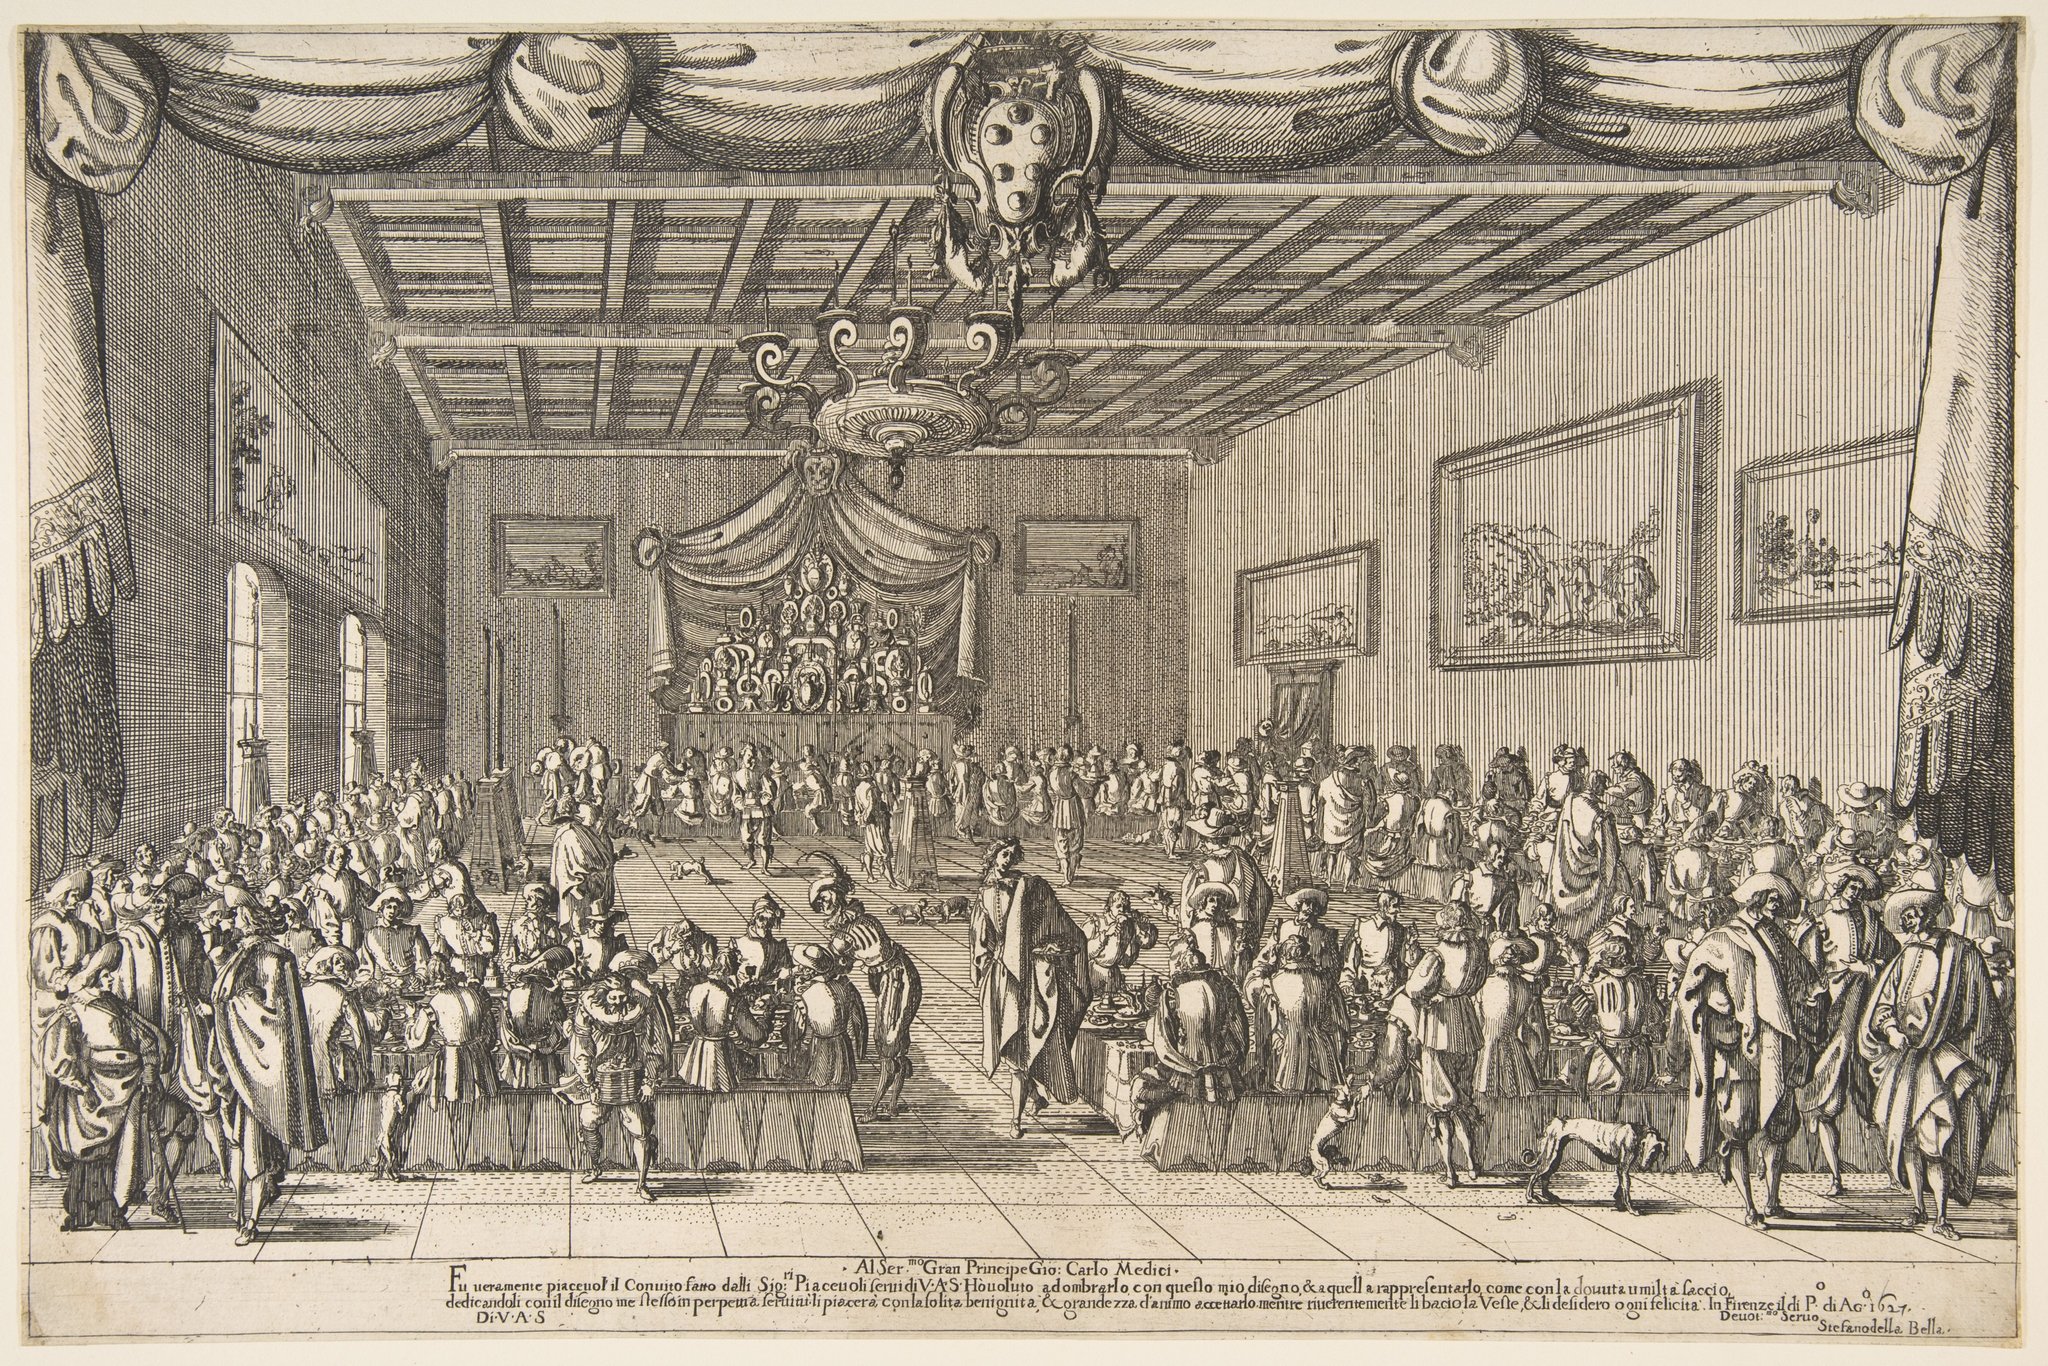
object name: print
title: Banquet of the Piacevoli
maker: stefano della bella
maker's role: artist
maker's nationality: italian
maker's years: 1610-1664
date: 1627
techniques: etching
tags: party,crowd